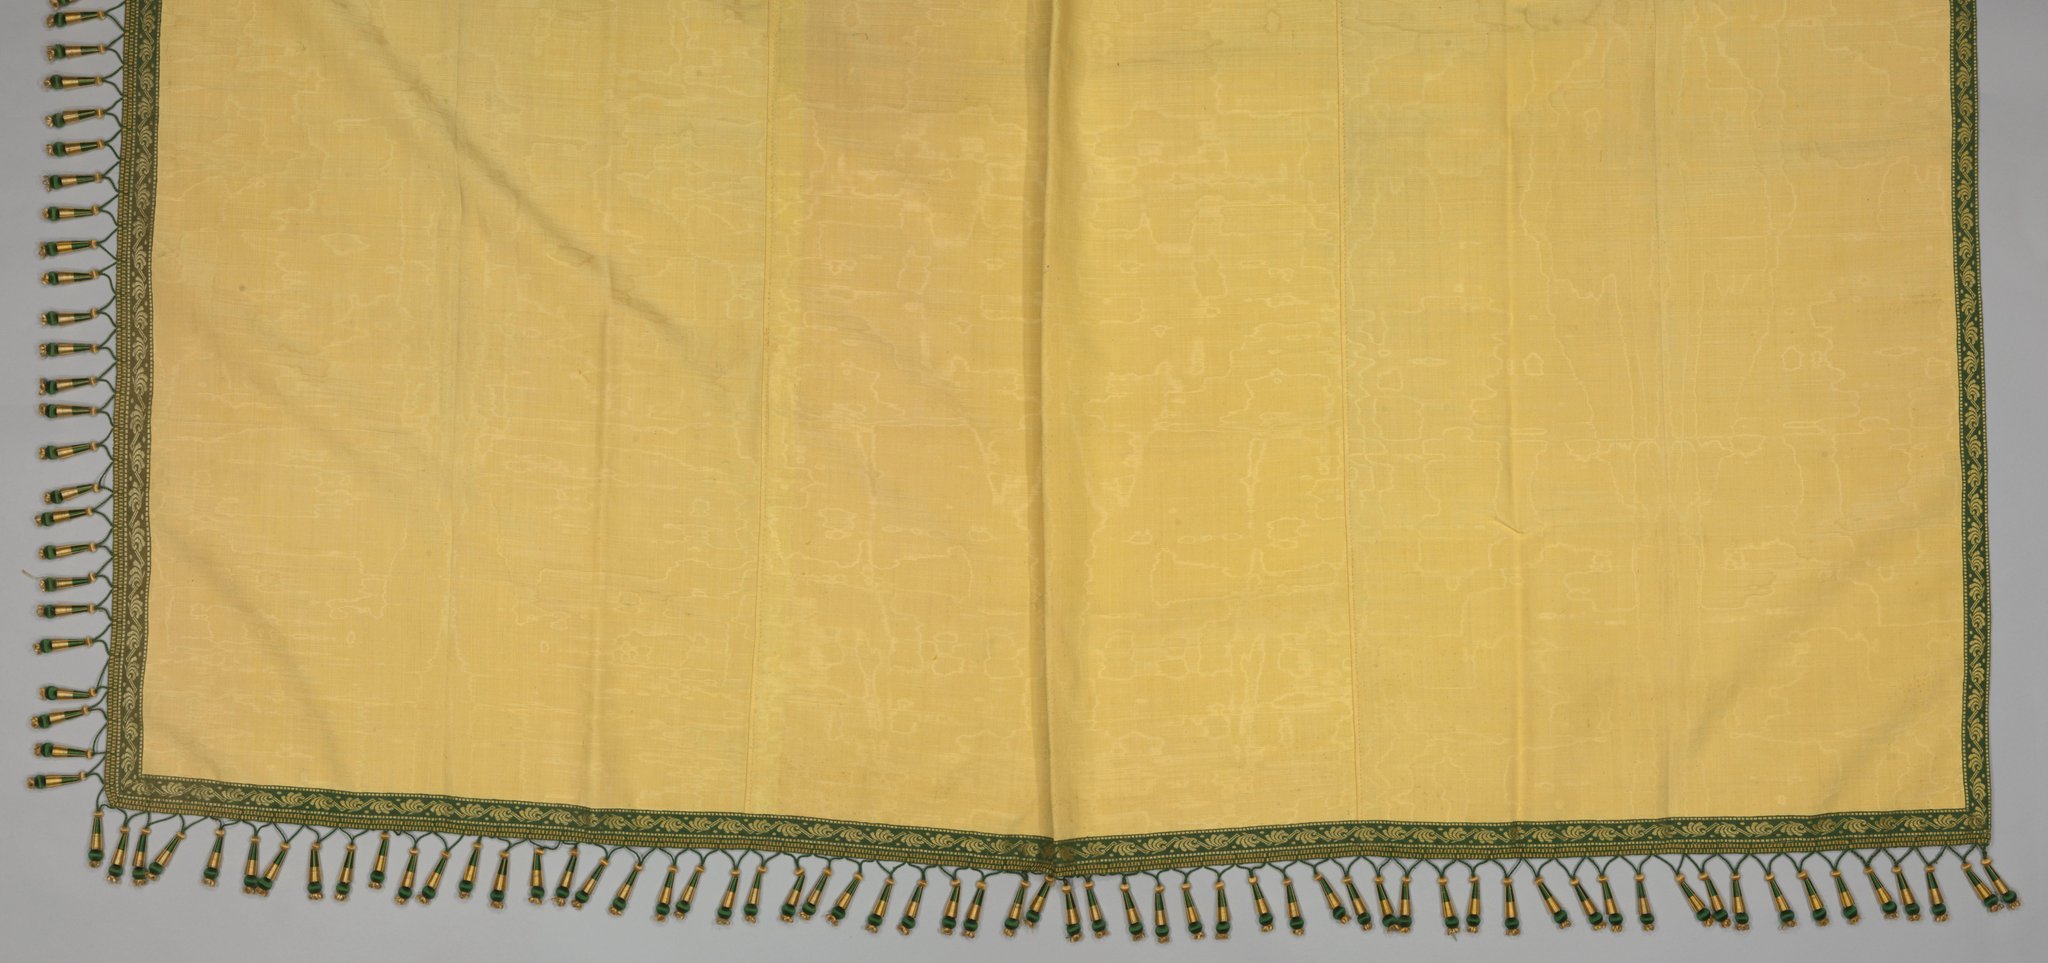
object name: bed curtain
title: Gordijn van een bedgarnituur van gele gewaterde wol met groen passement en afhangende klosjes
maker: Anonymous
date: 1795-1815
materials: silk, wool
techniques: moire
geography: northern netherlands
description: Gordijn van een bedgarnituur van gele gewaterde wol, omboord met groen passement met een geel motief en met een groen en geel boordsel met afhangende klosjes die met gele en groene zijde zijn omwonden.